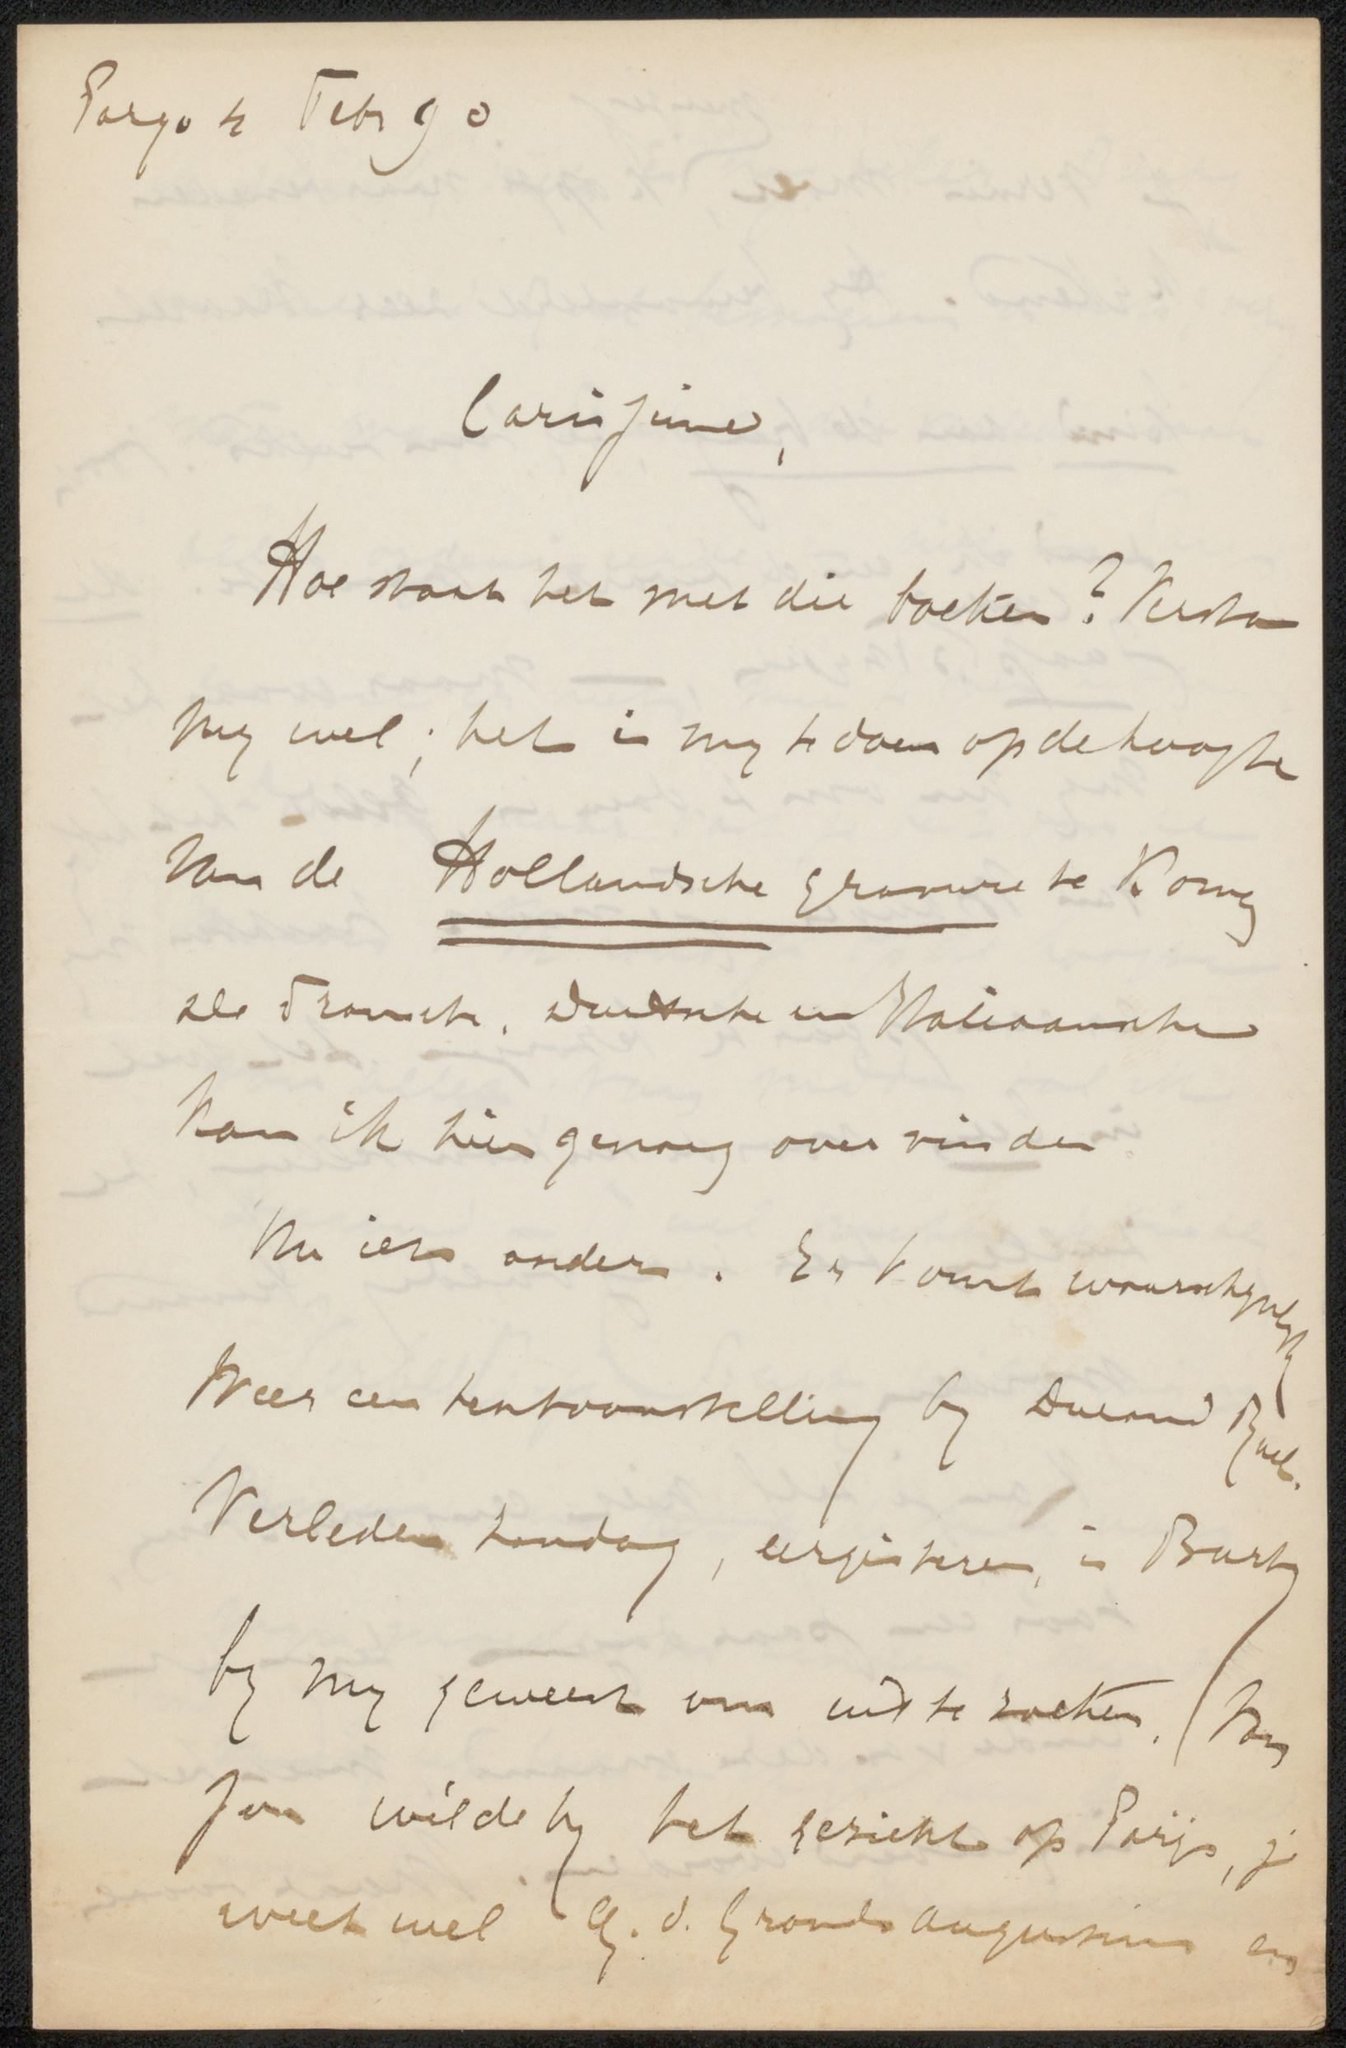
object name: letter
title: Brief aan Philip Zilcken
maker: adriaan pit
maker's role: print maker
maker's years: 1860-1944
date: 1890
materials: ink, paper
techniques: pen, writing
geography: paris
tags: paris, philippe burty, arnhem, painter, print maker, draughtsman, anton mauve, marinus van der maarel, félix hilaire buhot, philip zilcken, the graphic arts, exhibition ~ art, printed matter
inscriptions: collector's mark: ‘RPK’